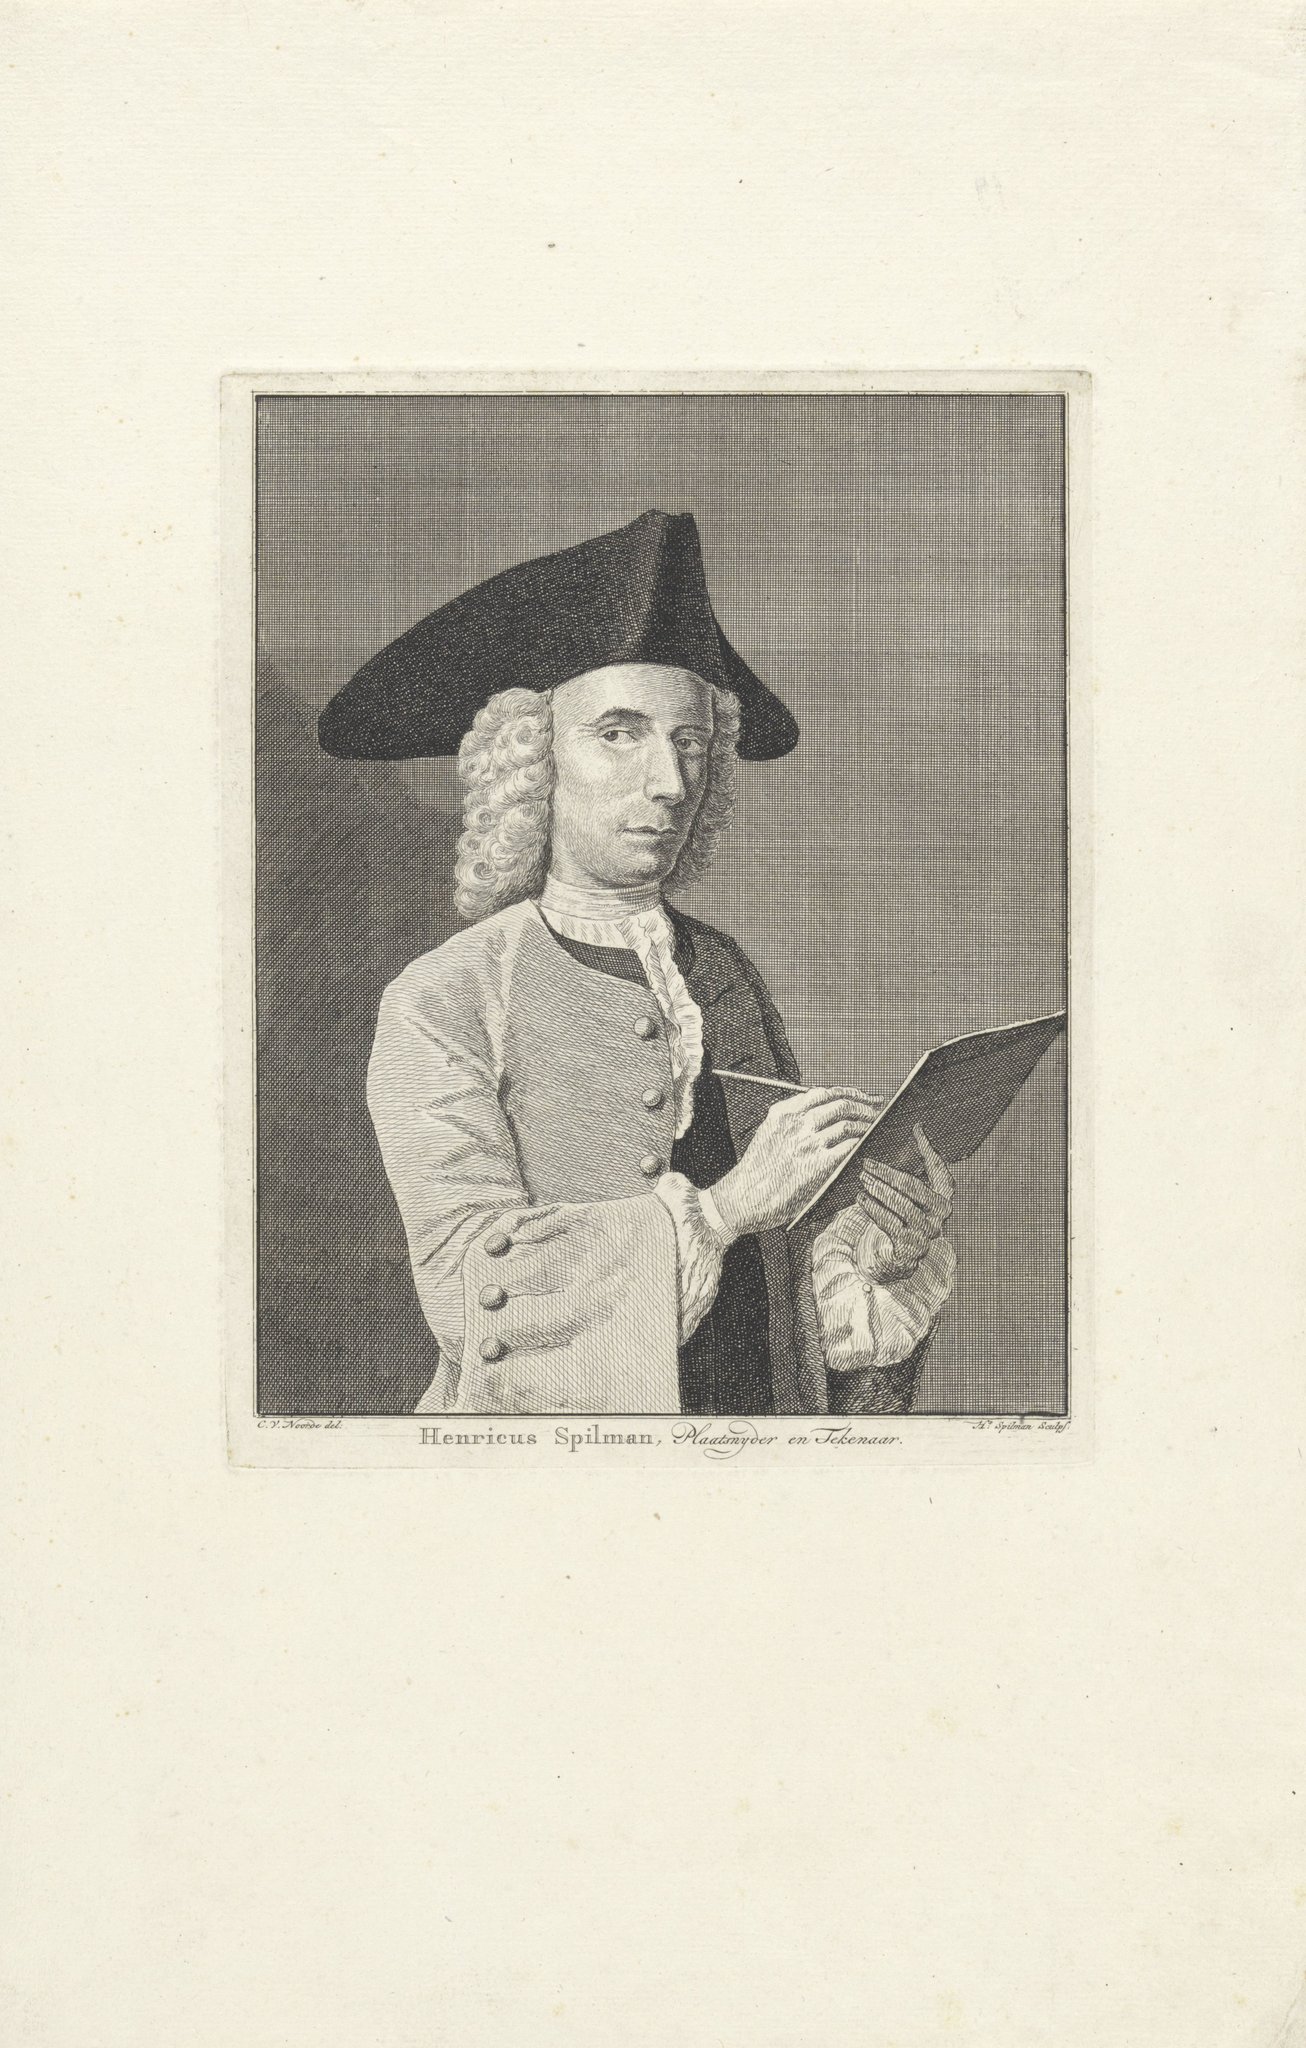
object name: print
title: Portret van Hendrik Spilman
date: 1742-1784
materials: paper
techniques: etching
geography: haarlem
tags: amsterdam, haarlem, painter, print maker, draughtsman, hendrik spilman, historical persons, portrait, self-portrait of graphic artist, portrait, self-portrait of draughtsman